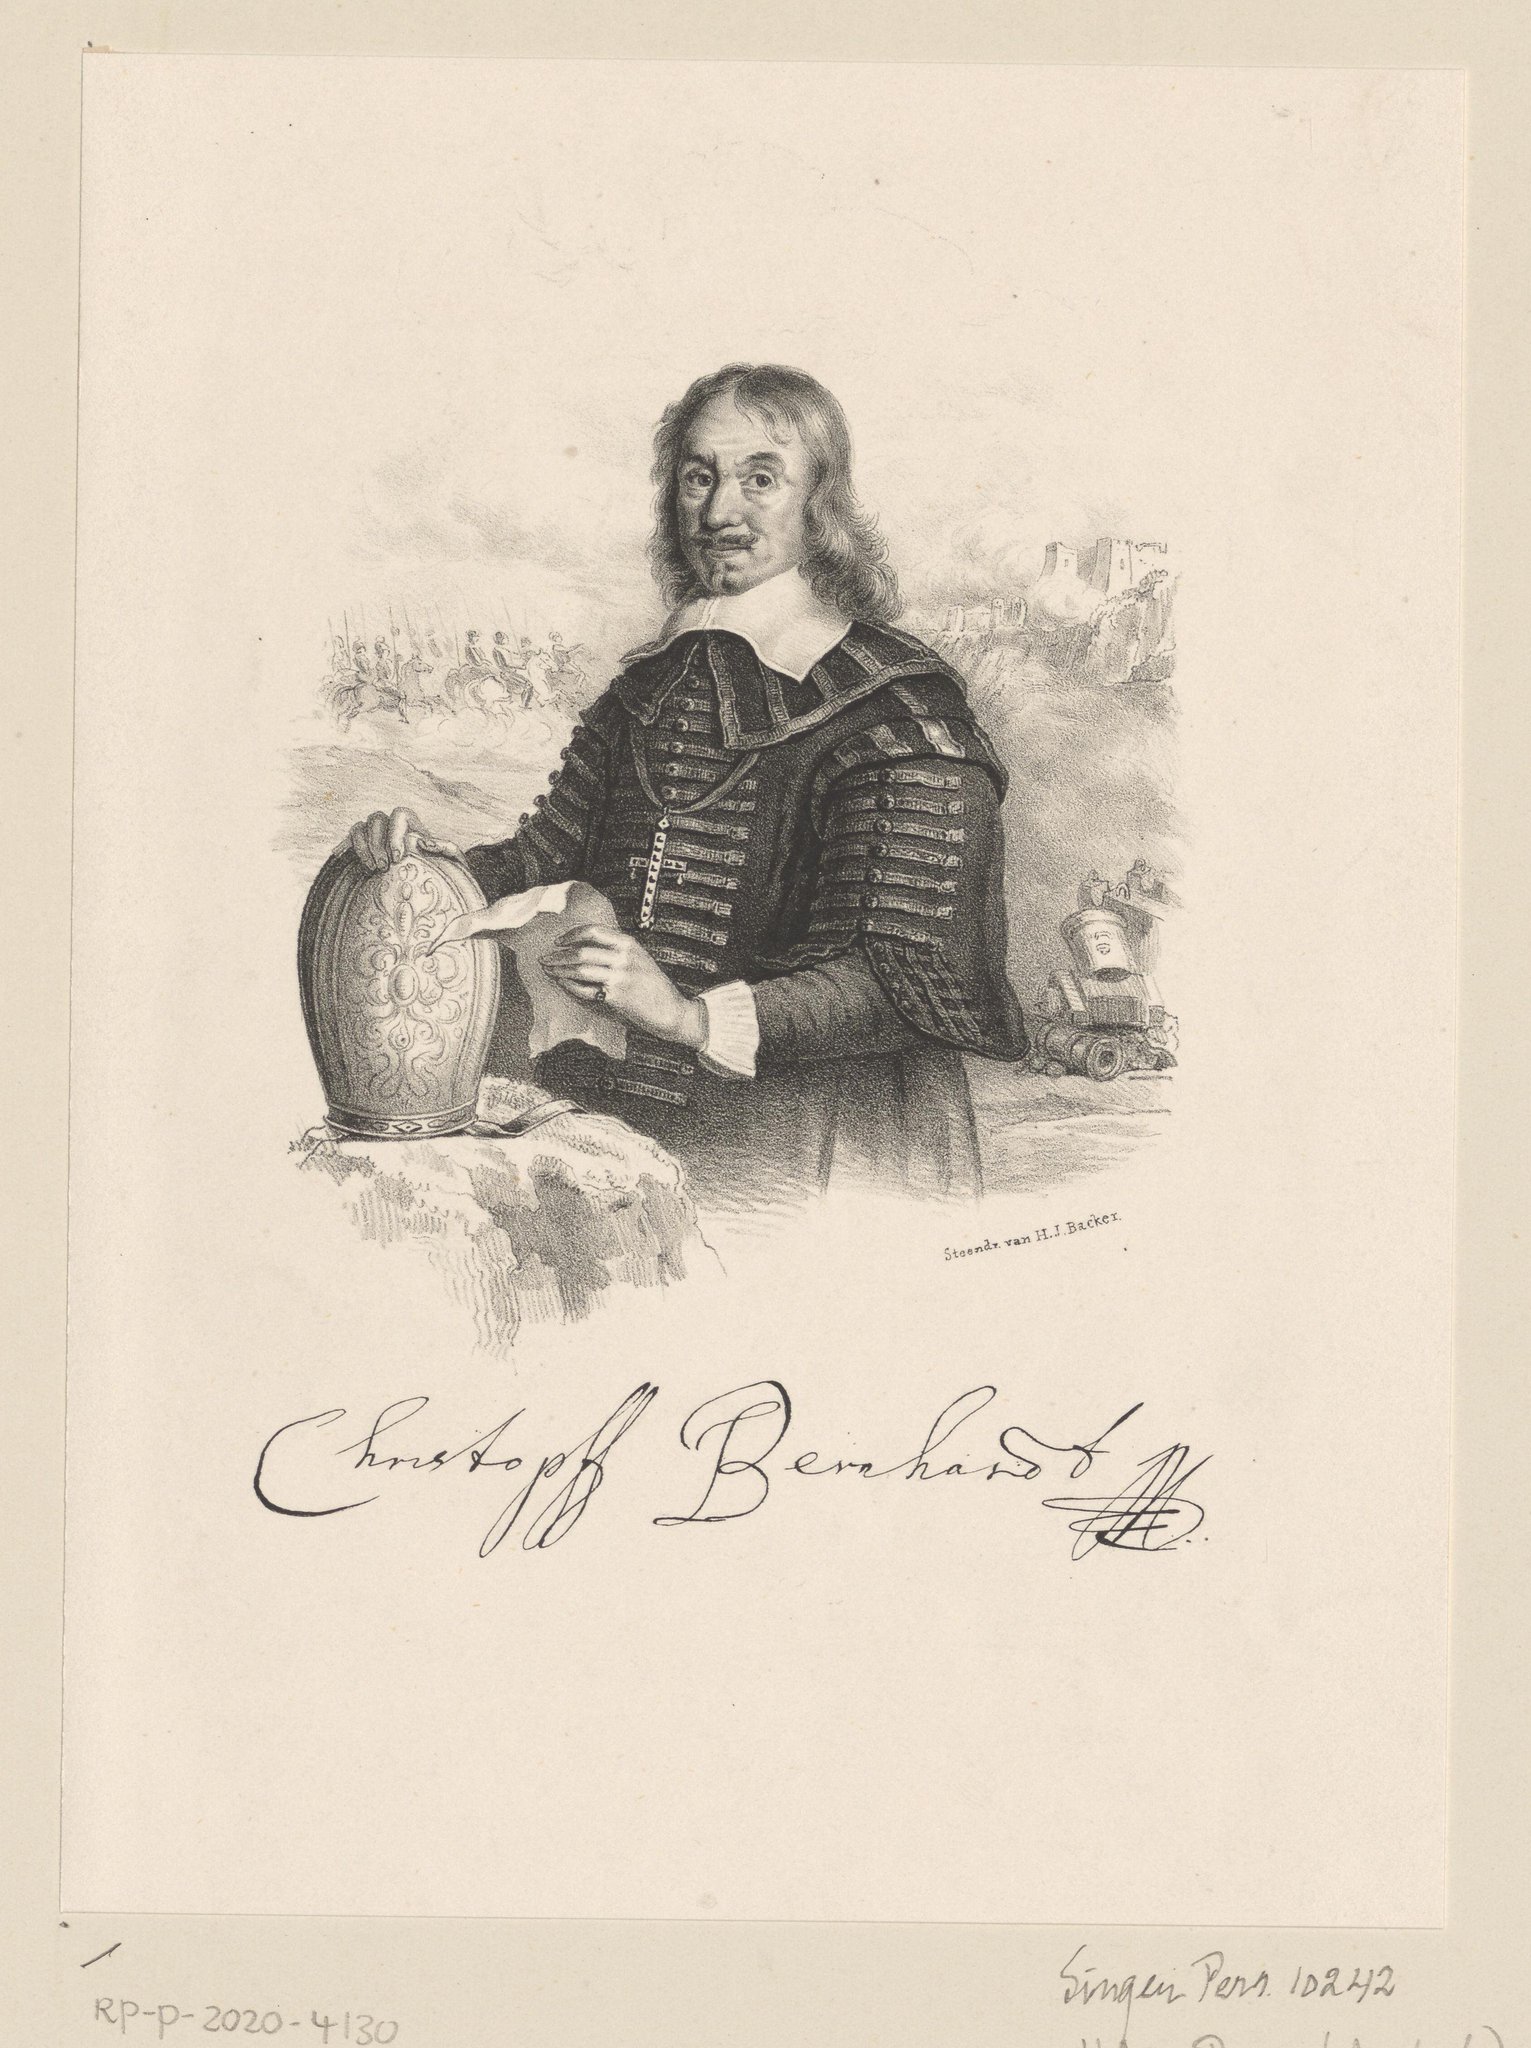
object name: print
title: Portret van Christoph Bernhard von Galen, bisschop van Münster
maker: hilmar johannes backer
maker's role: print maker, printer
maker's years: 1804-1845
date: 1814-1845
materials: paper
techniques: lithograph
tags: theologian, historical persons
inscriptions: collector's mark: Lugt 2233